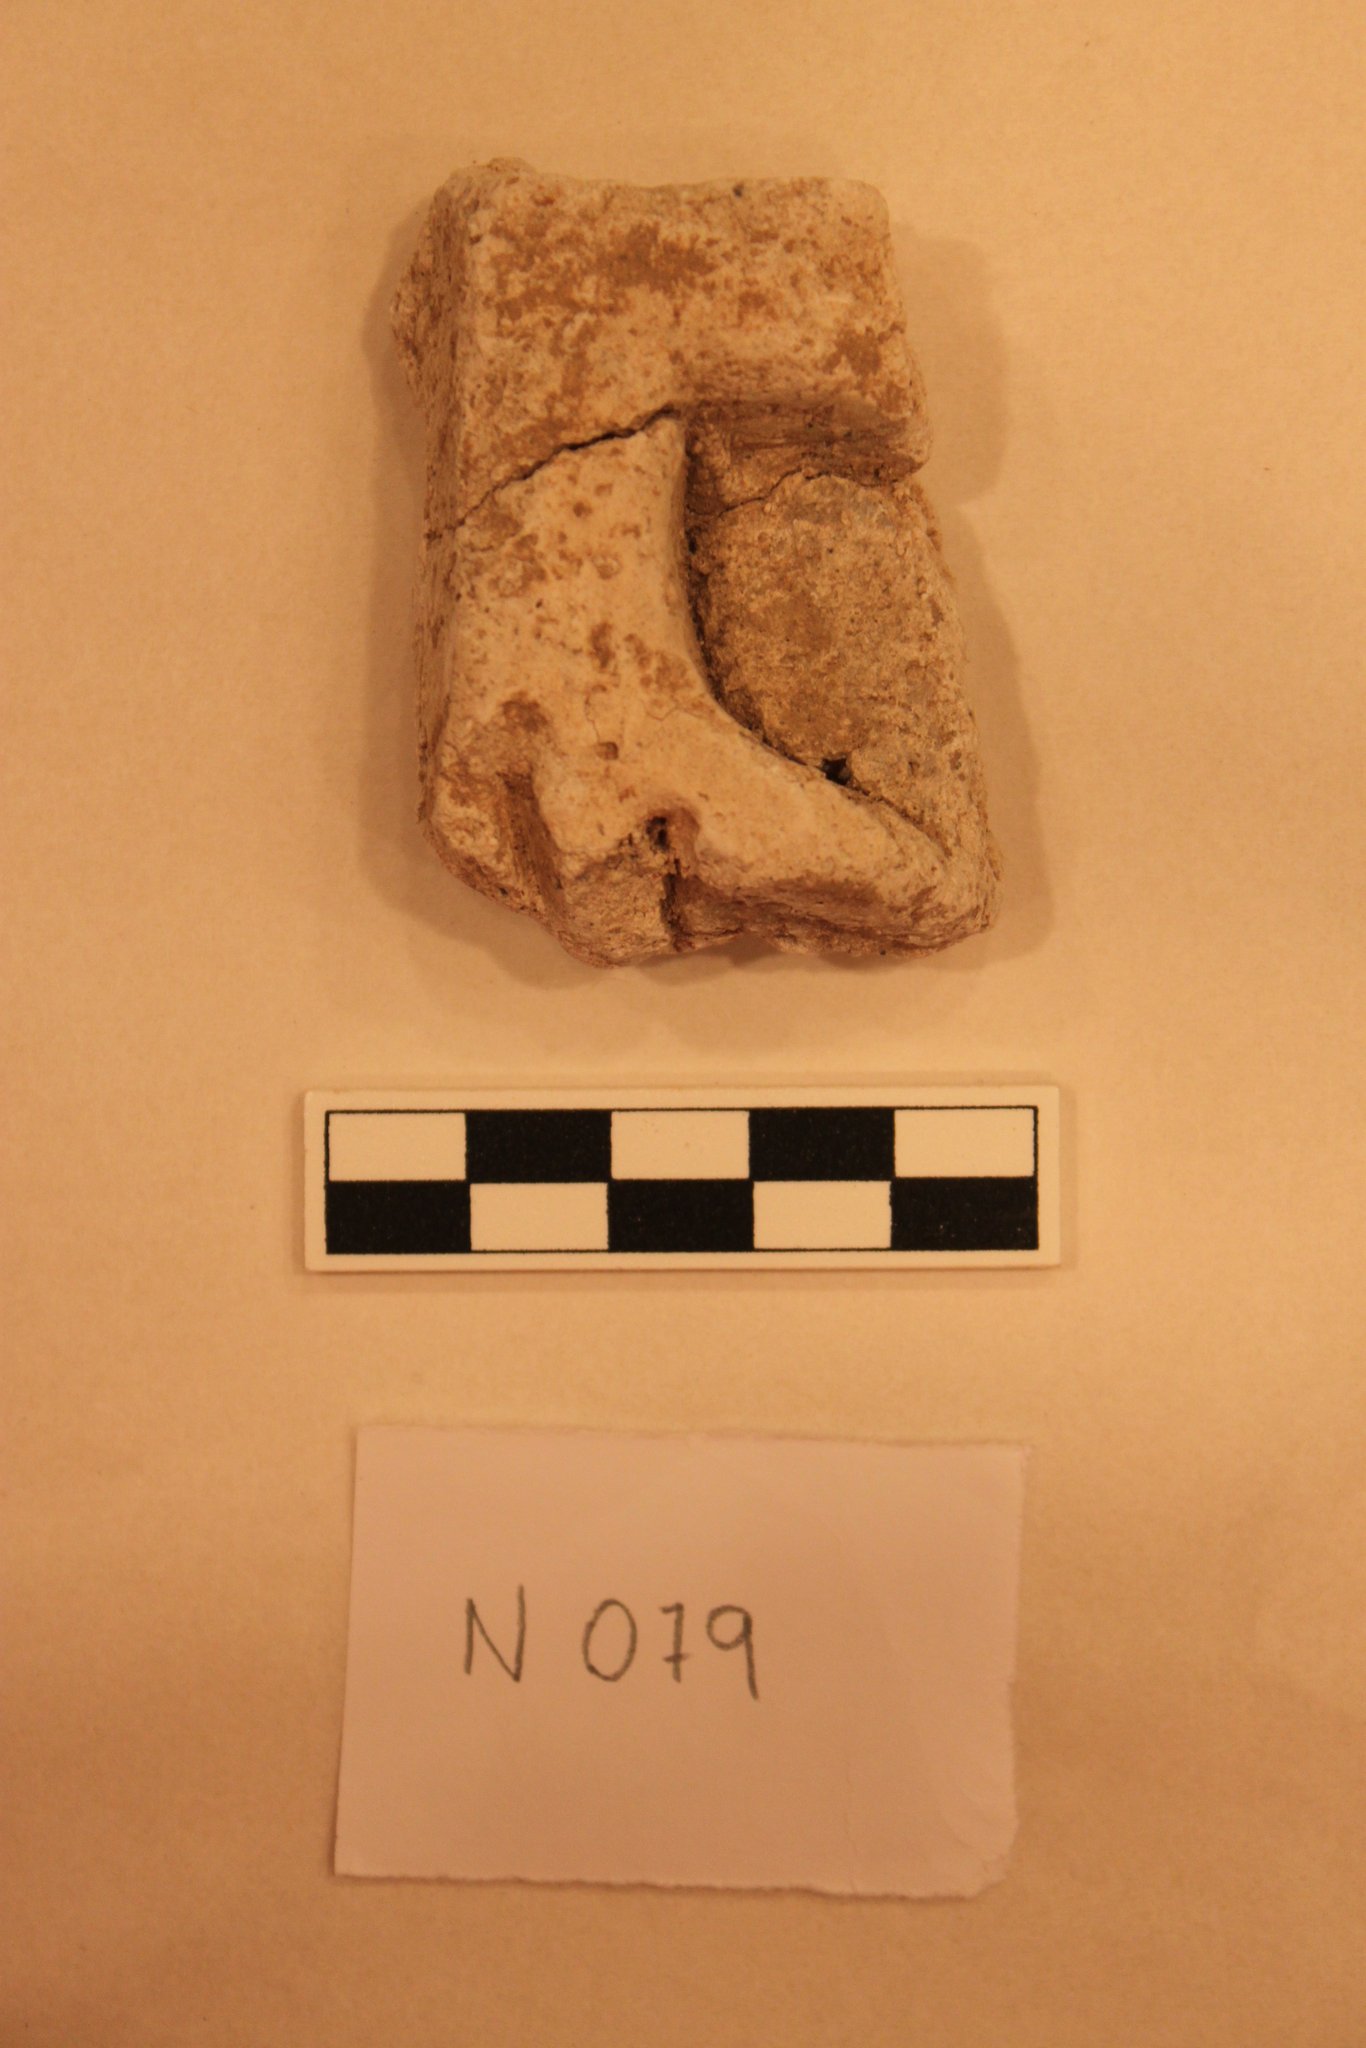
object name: fragment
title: Stucco Fragment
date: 701-1200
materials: plaster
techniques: carving, painting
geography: iran